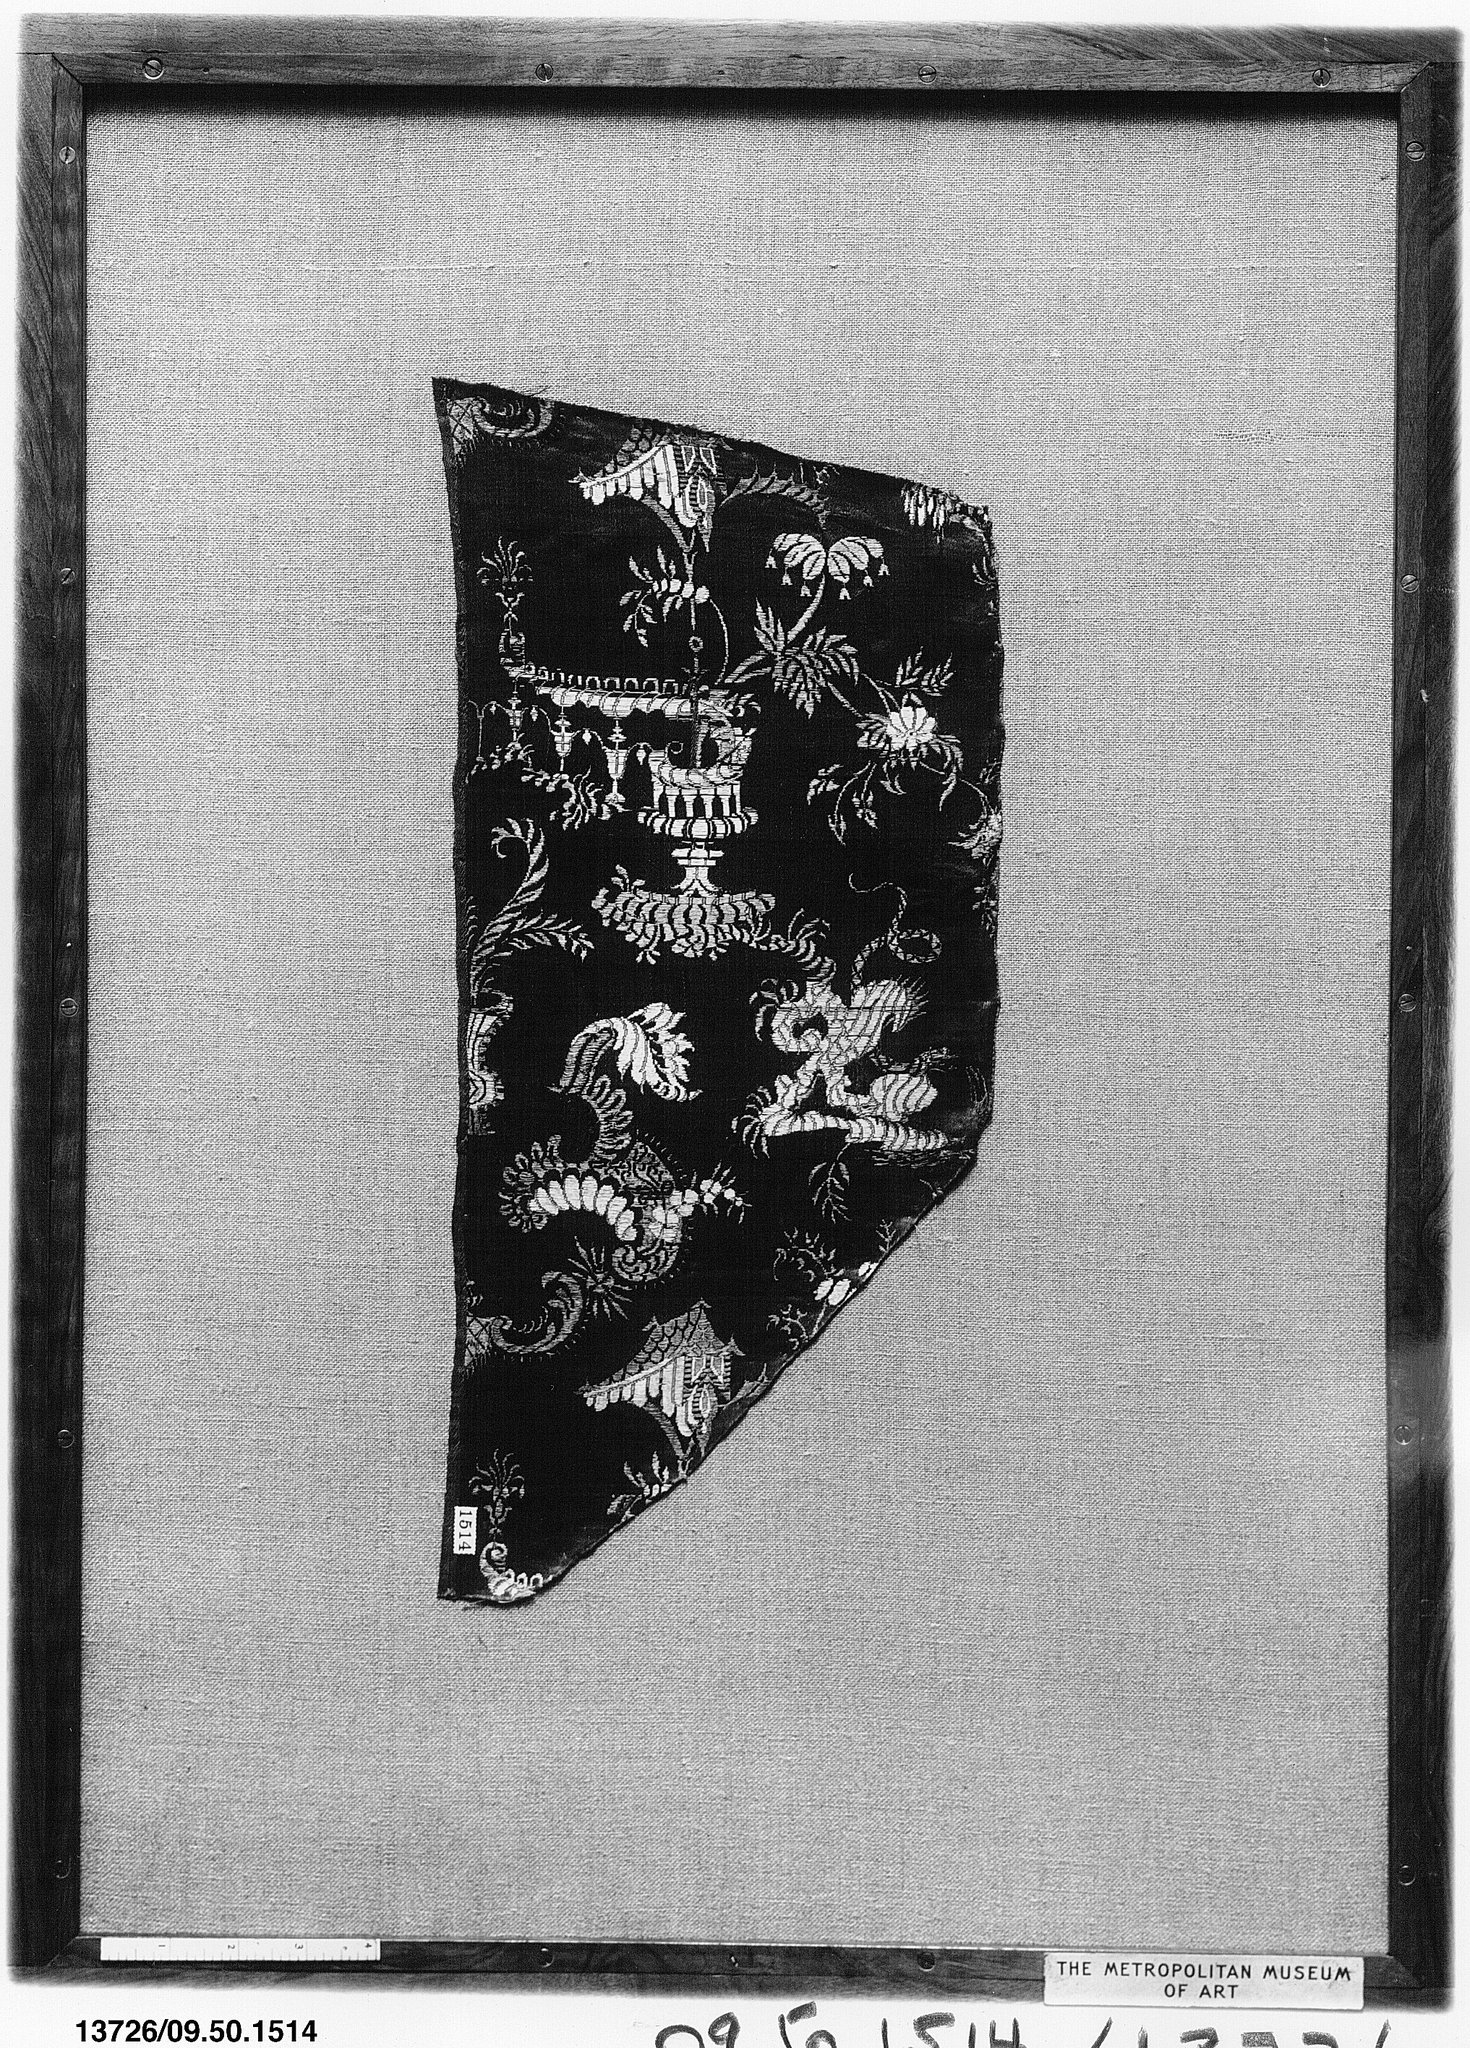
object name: piece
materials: silk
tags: flowers,leaves